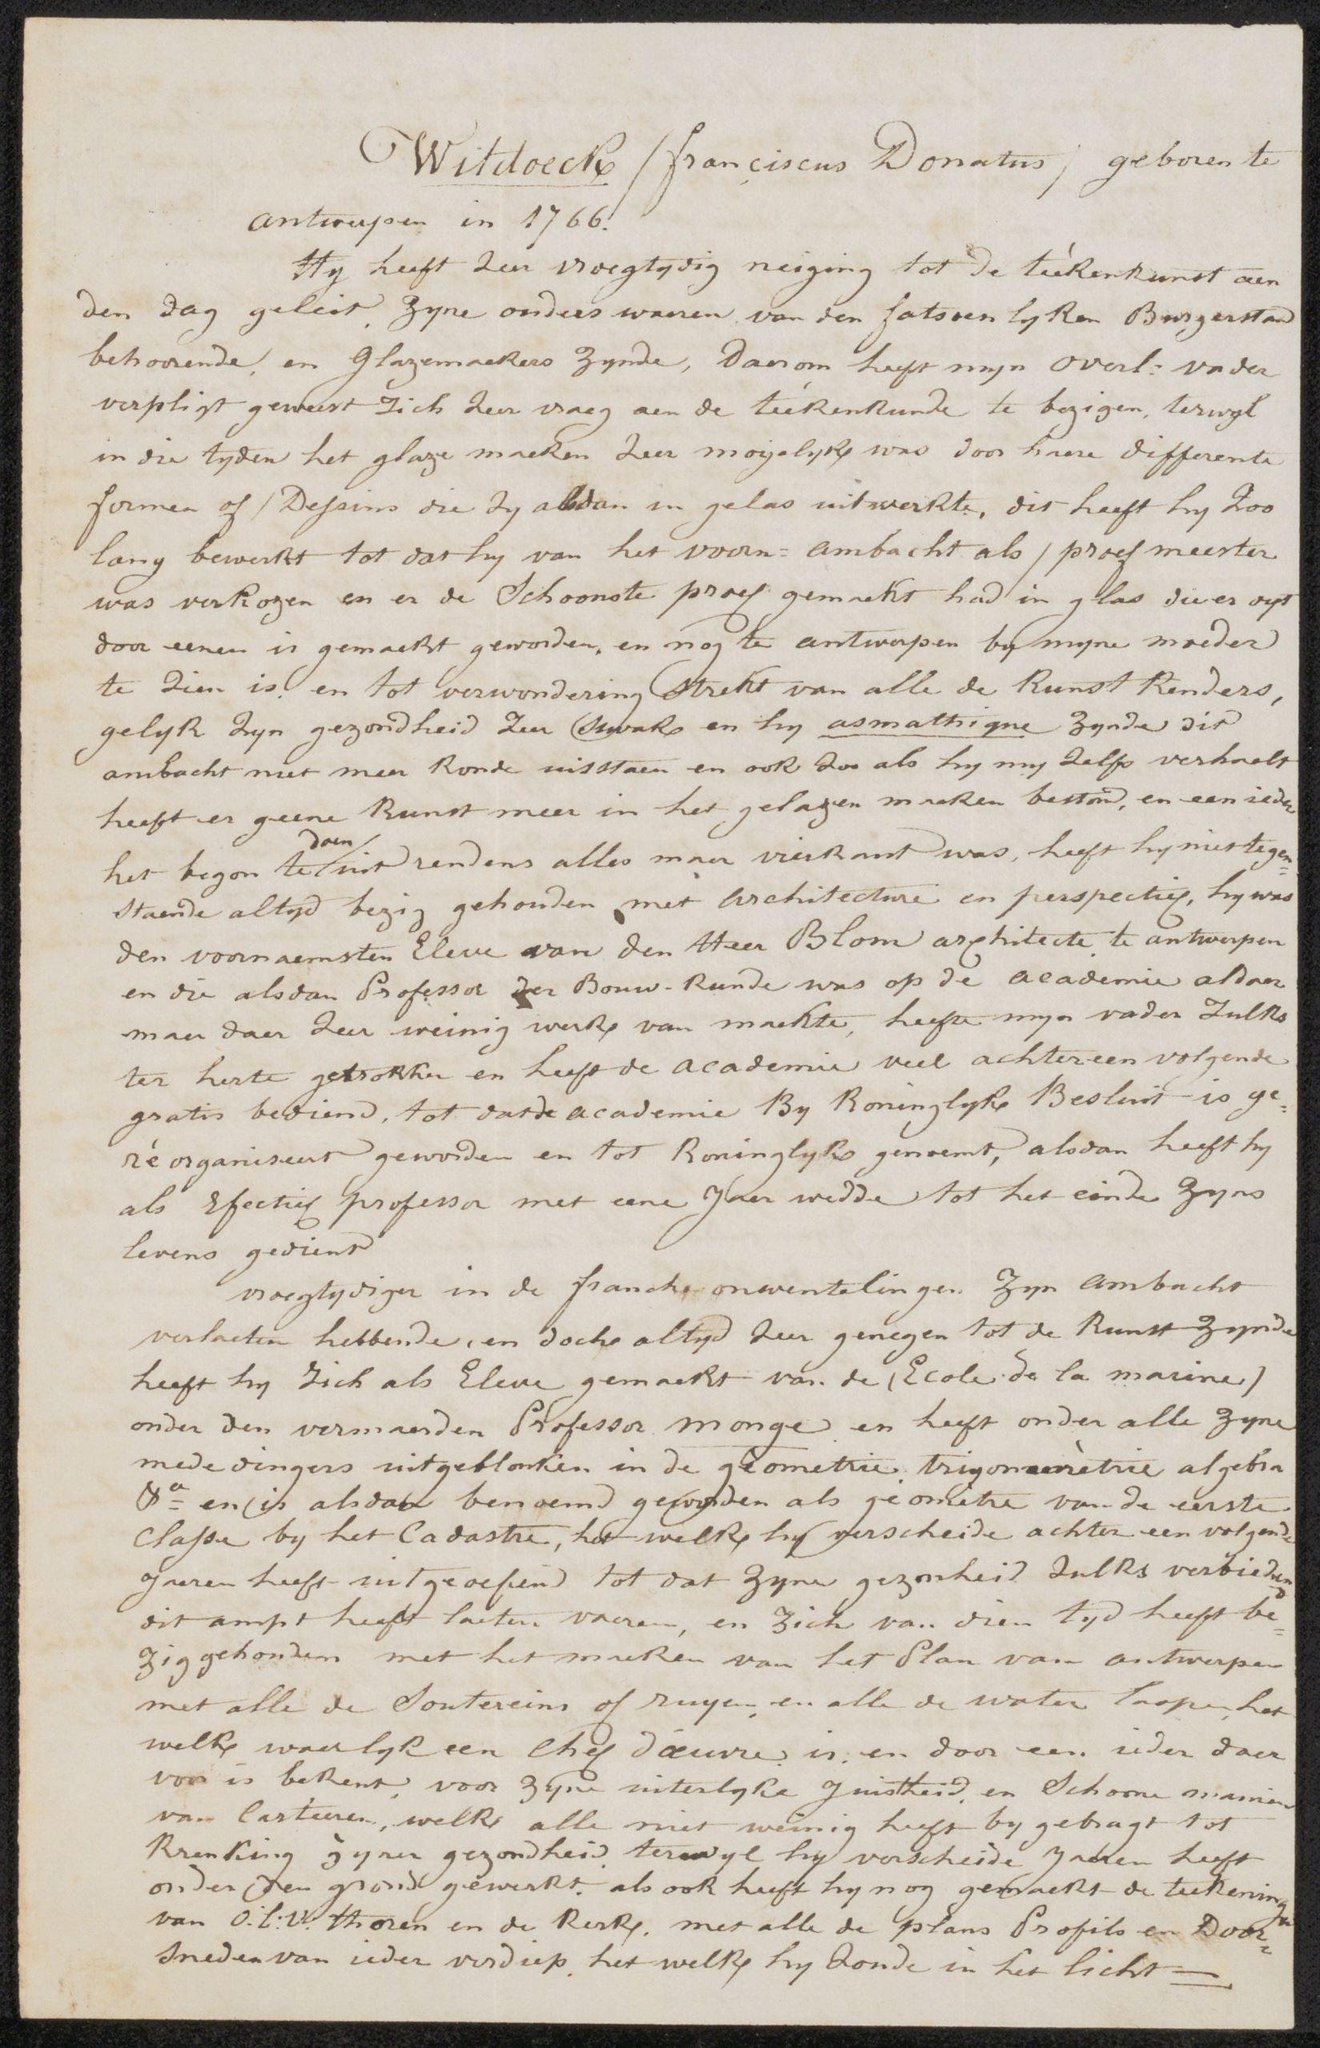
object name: manuscript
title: Handschrift betreffende Franciscus Donatus Witdoeck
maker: Anonymous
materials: ink, paper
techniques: pen, writing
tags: draughtsman, architecture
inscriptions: collector's mark: Lugt 2233